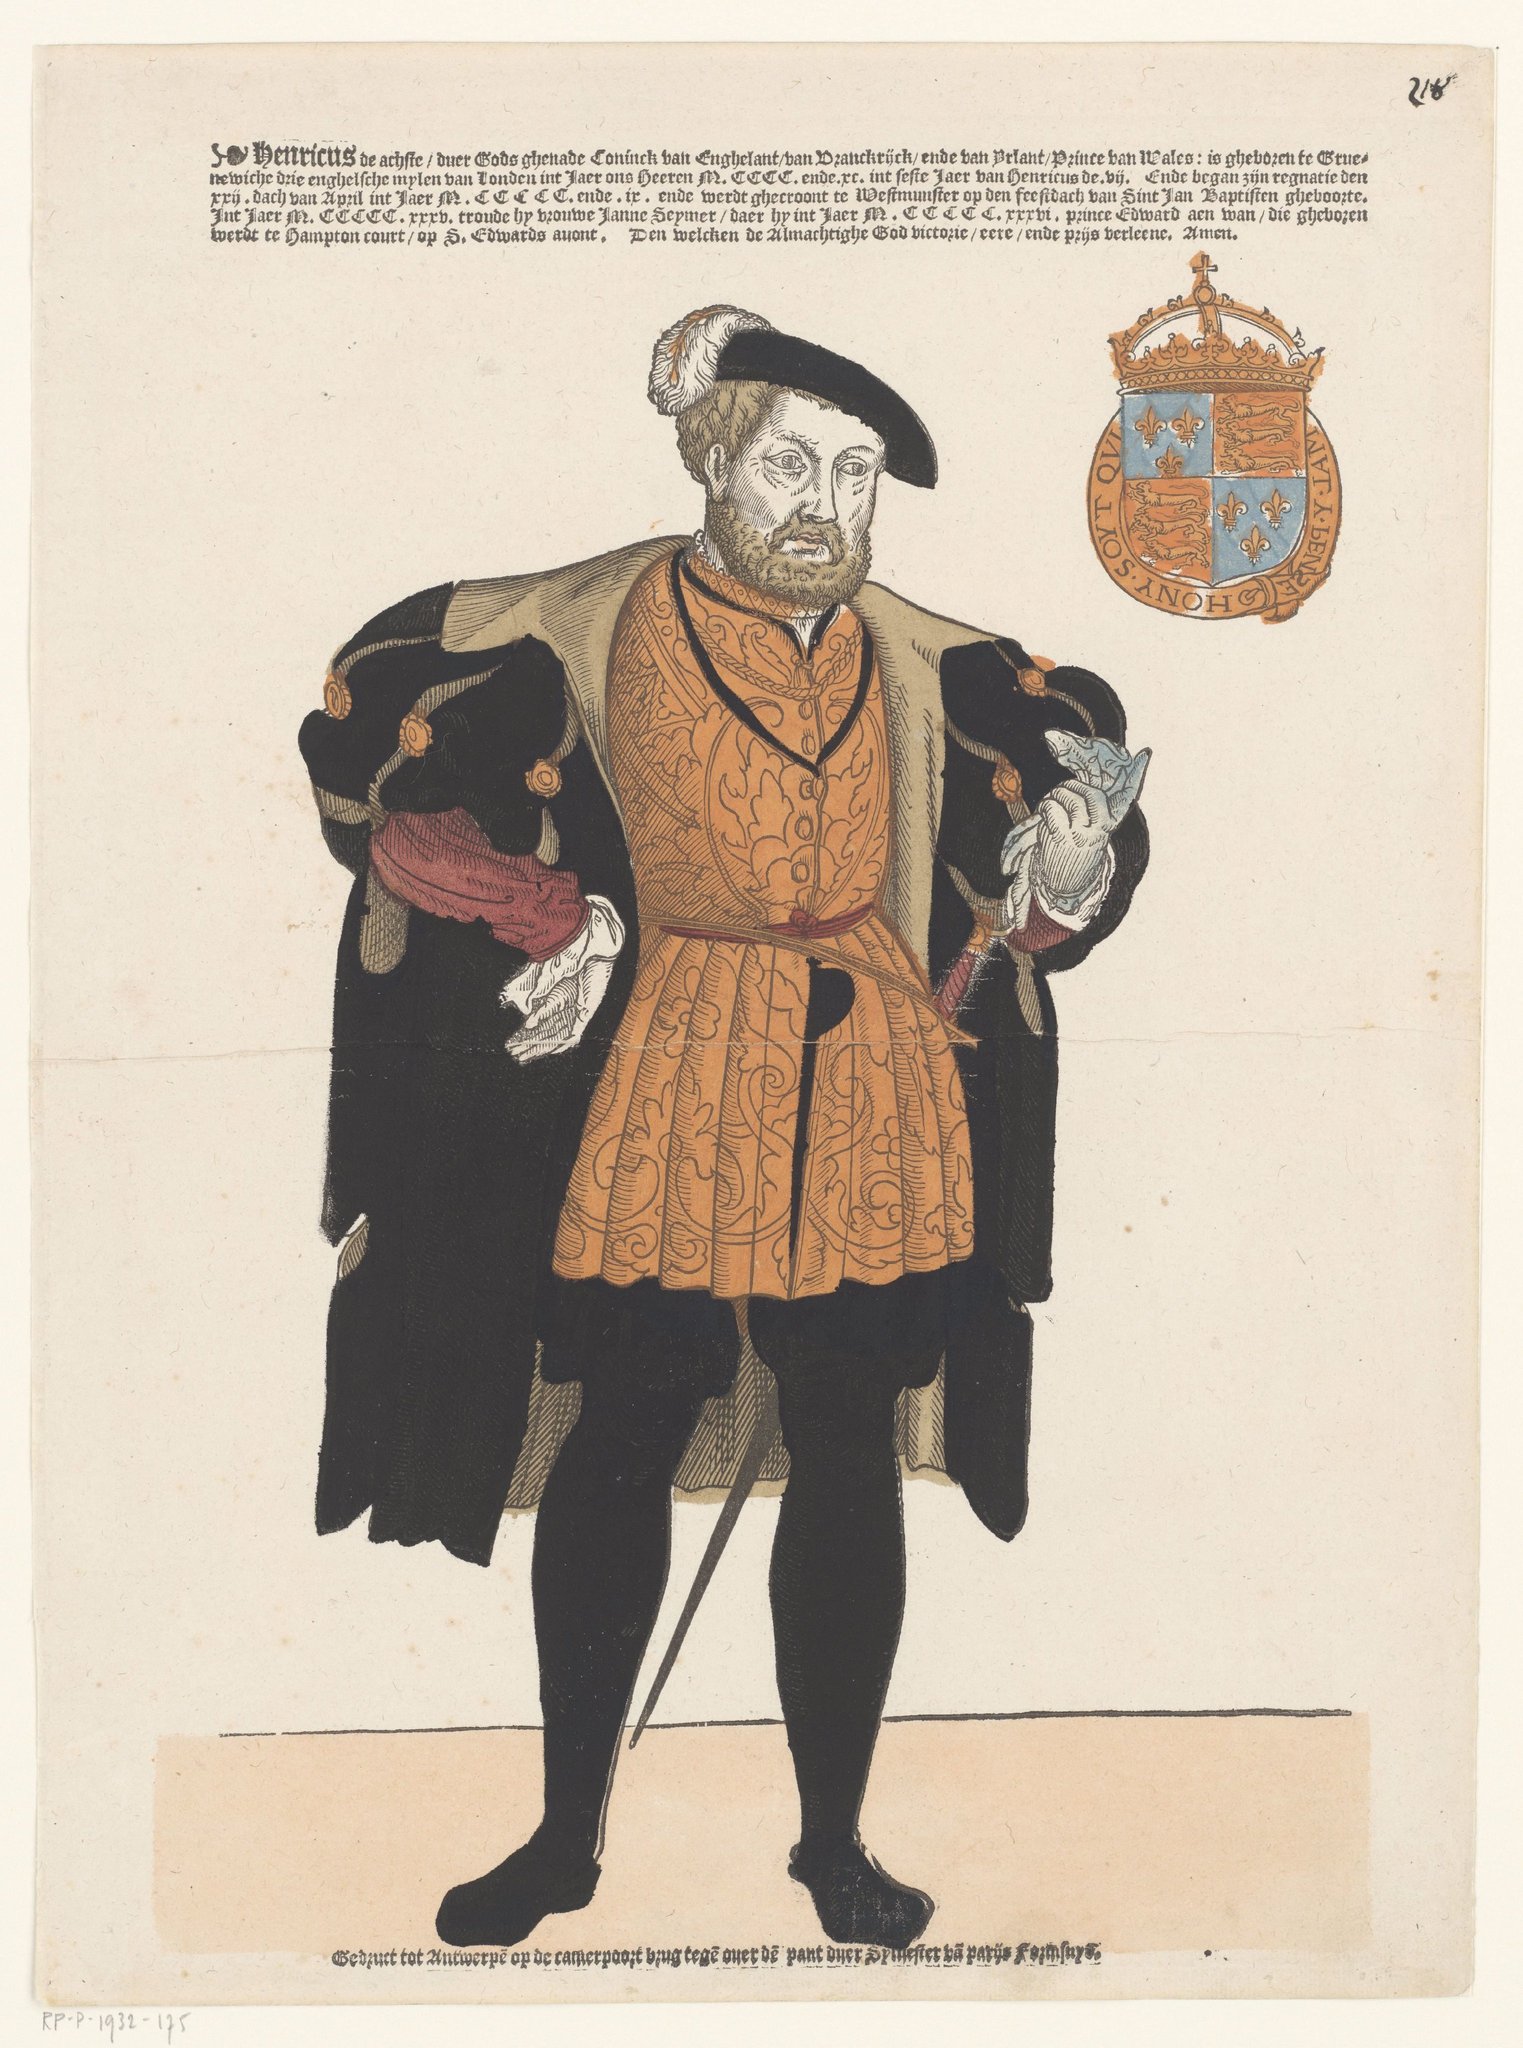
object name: print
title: Portret van Hendrik VIII van Engeland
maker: sylvester van parijs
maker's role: publisher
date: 1538-1548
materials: paper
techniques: hand coloring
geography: antwerp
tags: gloves, mittens, etc., historical persons, king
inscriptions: number: ‘218’, address: ‘Gedruct tot Antwerpe[n] op de camerpoort brug tege[n] over de[n] pant duer Sylvester va[n] parijs Formsnyd.’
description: Hendrik VIII, koning van Engeland, gekleed in tabbaard, staand ten voeten uit. Een paar handschoenen in de hand. Rechtsboven zijn wapen en opschrift van vijf regels in het Nederlands: Henricus de achste...prijs verleene. Amen.